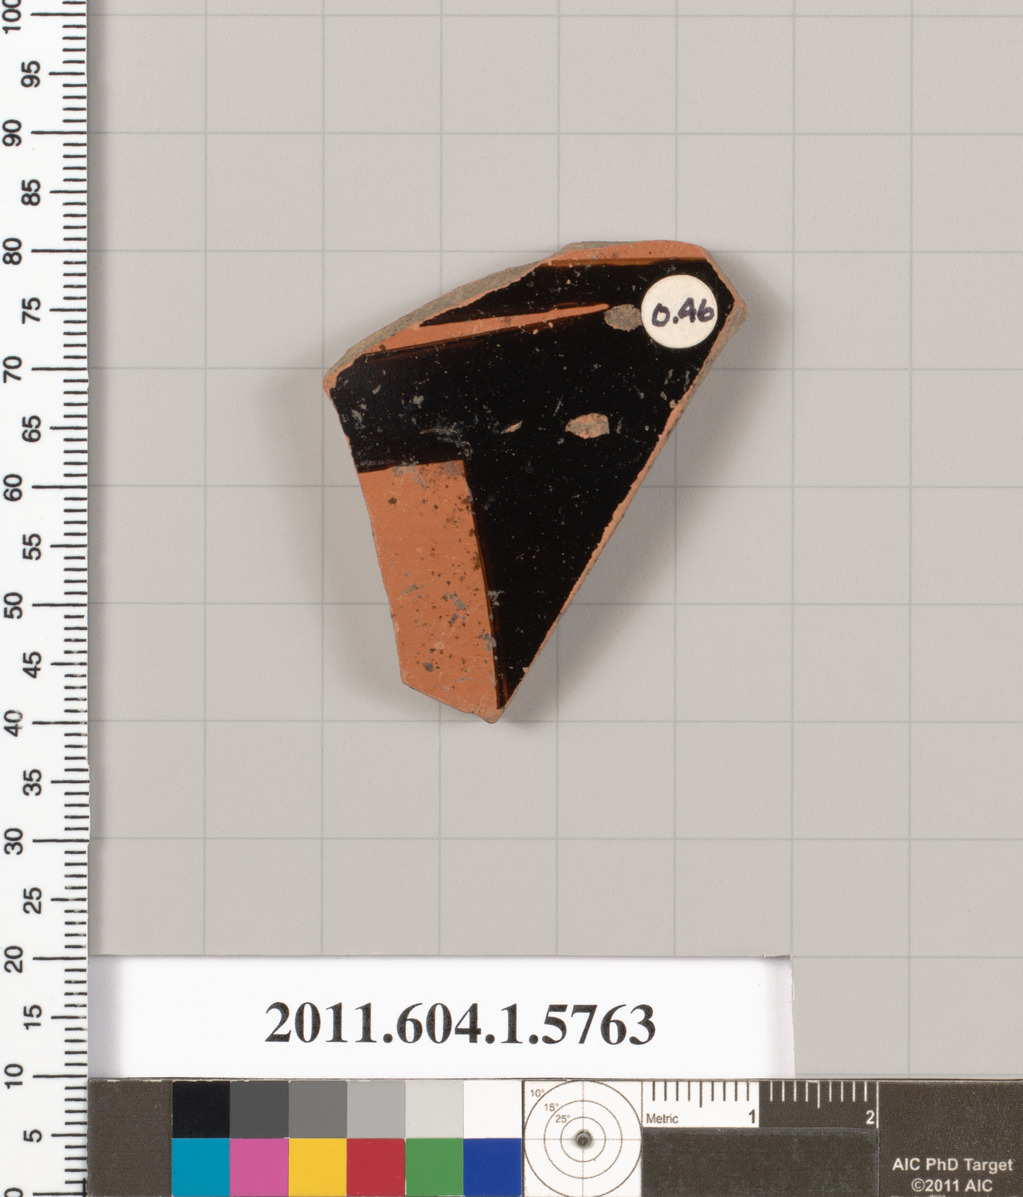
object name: kylix fragment, eye cup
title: Terracotta fragment of a kylix: eye-cup (drinking cup)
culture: greek, attic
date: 520-510 BCE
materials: terracotta